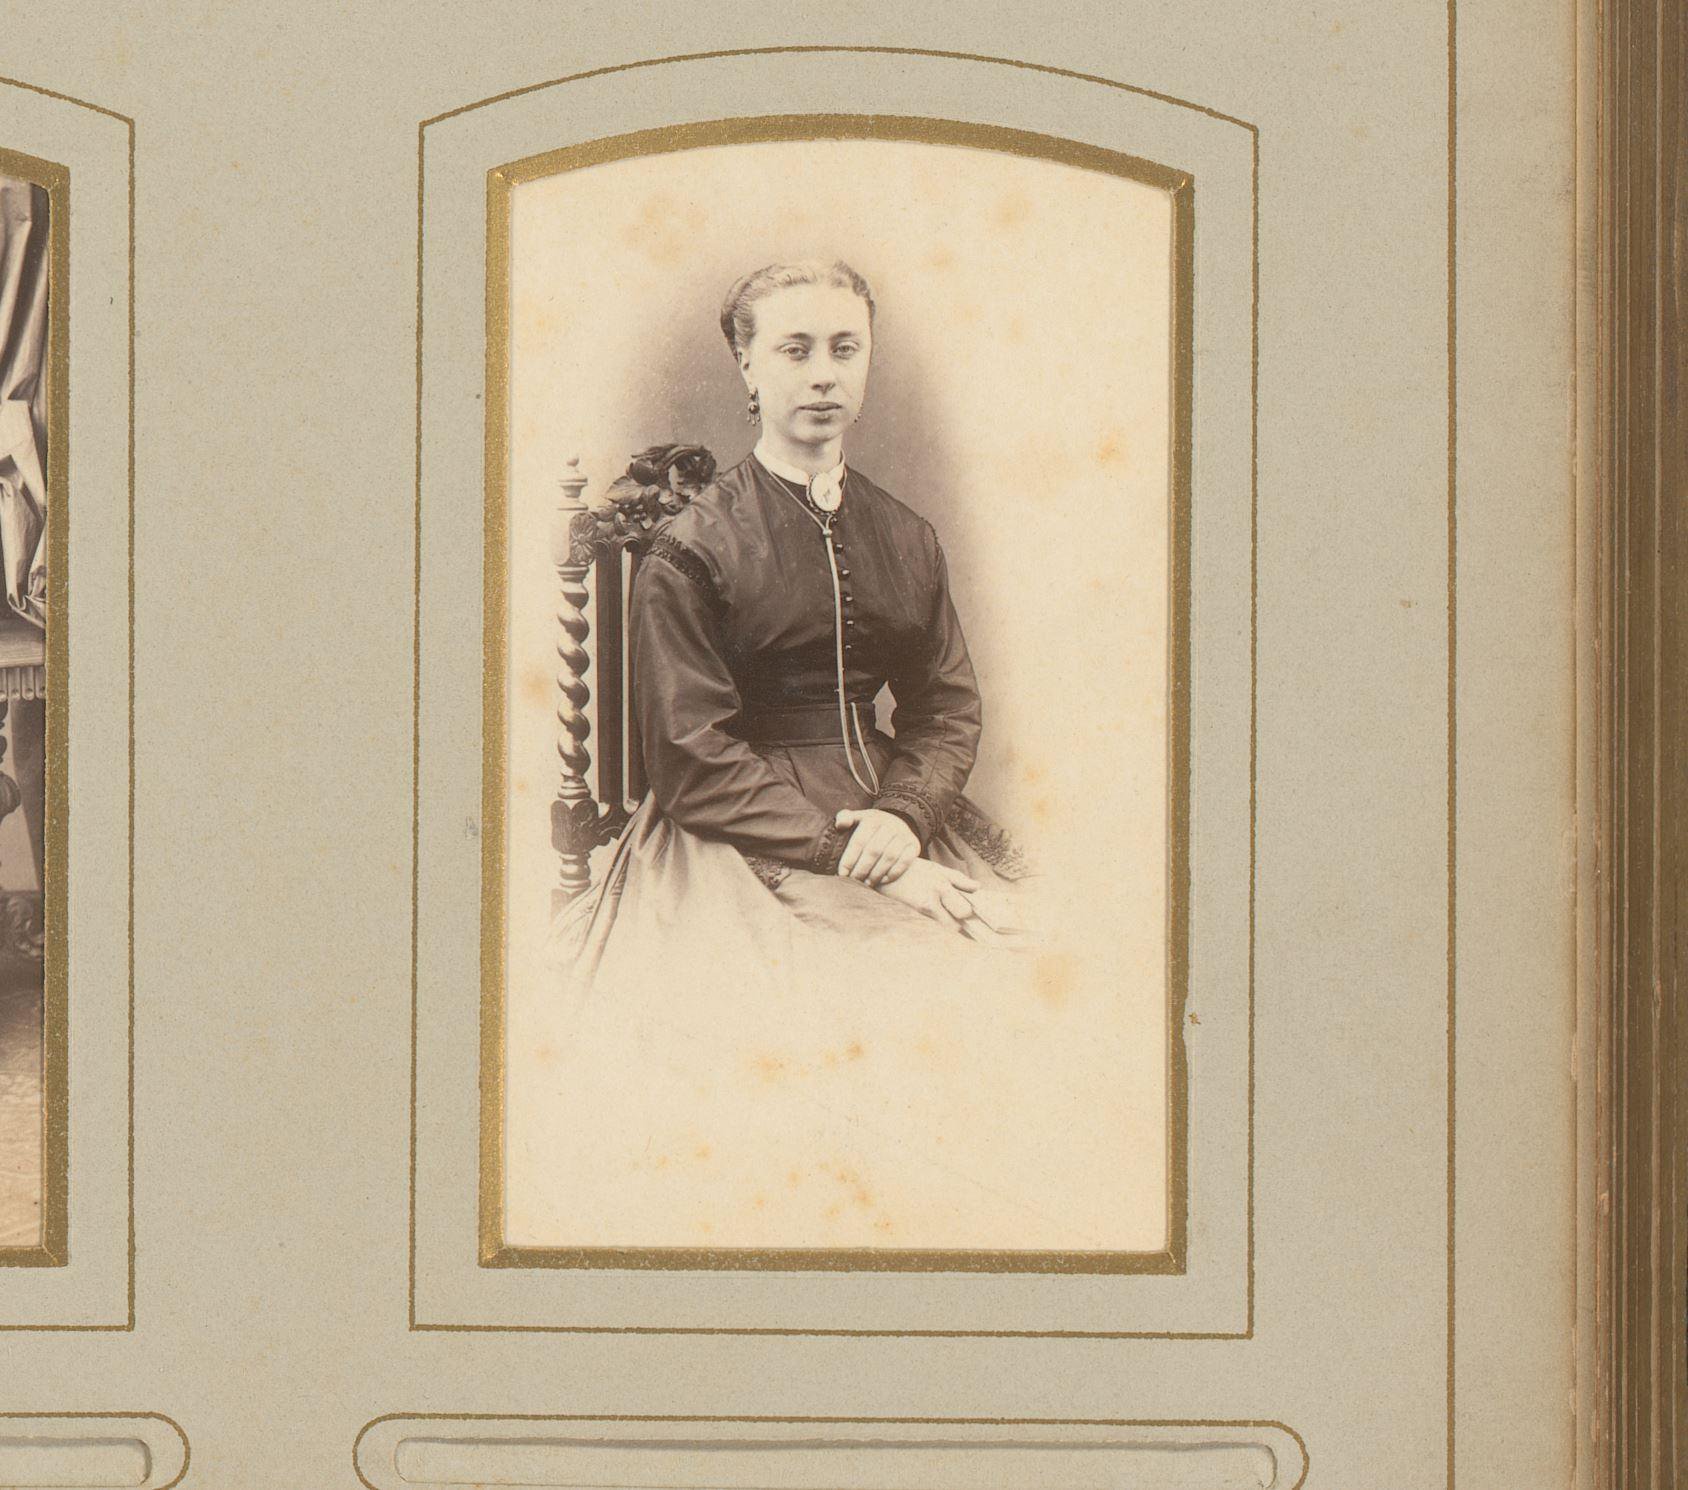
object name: carte de visite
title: Portret van een zittende jonge vrouw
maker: louis de laetre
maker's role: fotograaf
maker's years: 1815-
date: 1866-1869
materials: cardboard, photographic support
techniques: albumen print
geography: ghent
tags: sitting figure - aa - female human figure, historical persons - bb - woman, chair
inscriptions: inscription: ‘L. DE LAETRE/ PHOTOGRAPHE/ BREVETÉ POUR GROUPES/ Rue des Douze Chambres, No. 15/ GAND’